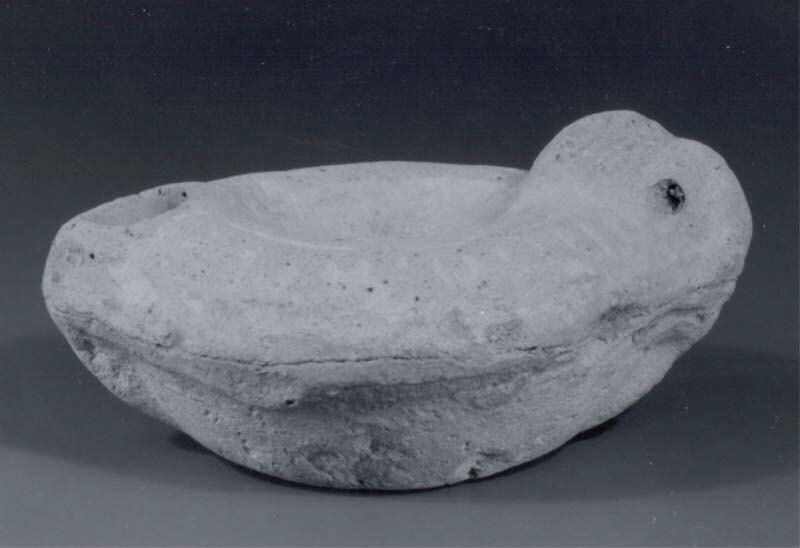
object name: lamp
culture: nabataean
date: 1-100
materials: ceramic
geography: levant